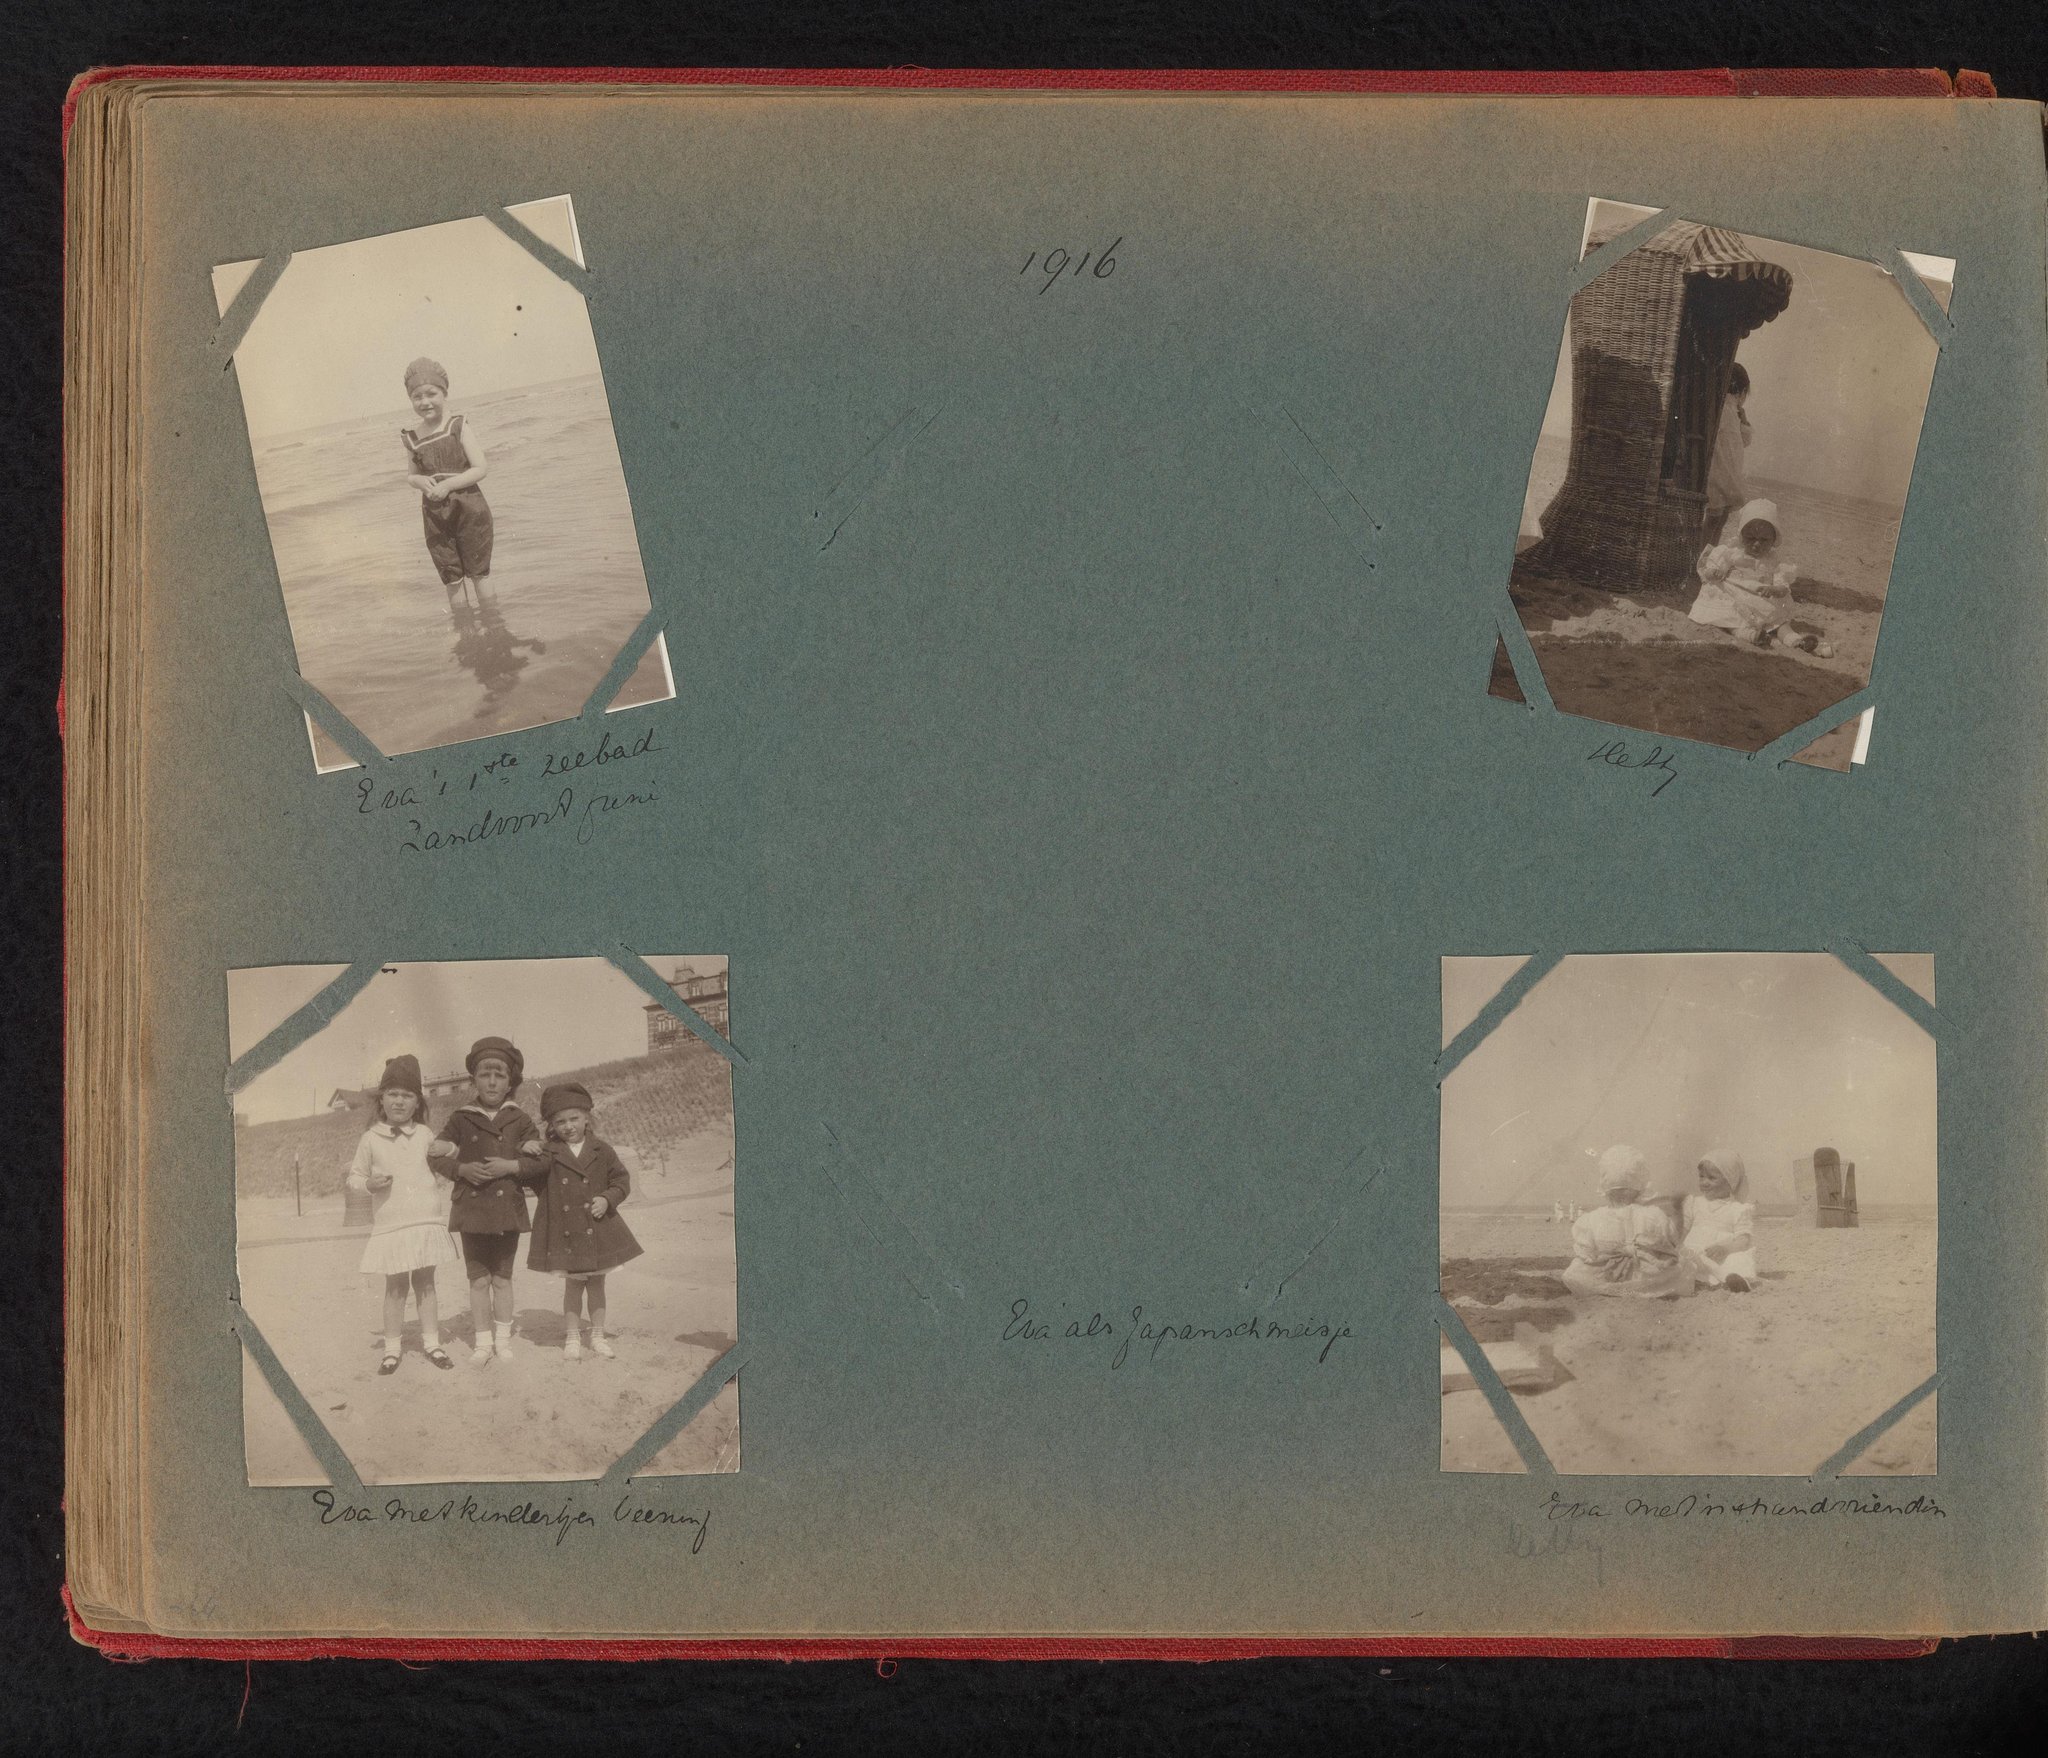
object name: photograph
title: Eva en Hetty Boelen op het strand van Zandvoort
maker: charlotte alida boelen-matthes (lot)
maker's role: amateurfotograaf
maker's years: 1889-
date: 1916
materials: paper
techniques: gelatin silver print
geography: zandvoort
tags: eva charlotte pennink-boelen, beach (as place of recreation), girl (child between toddler and youth), toddler (female)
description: Deze foto's zijn onderdeel van een album.